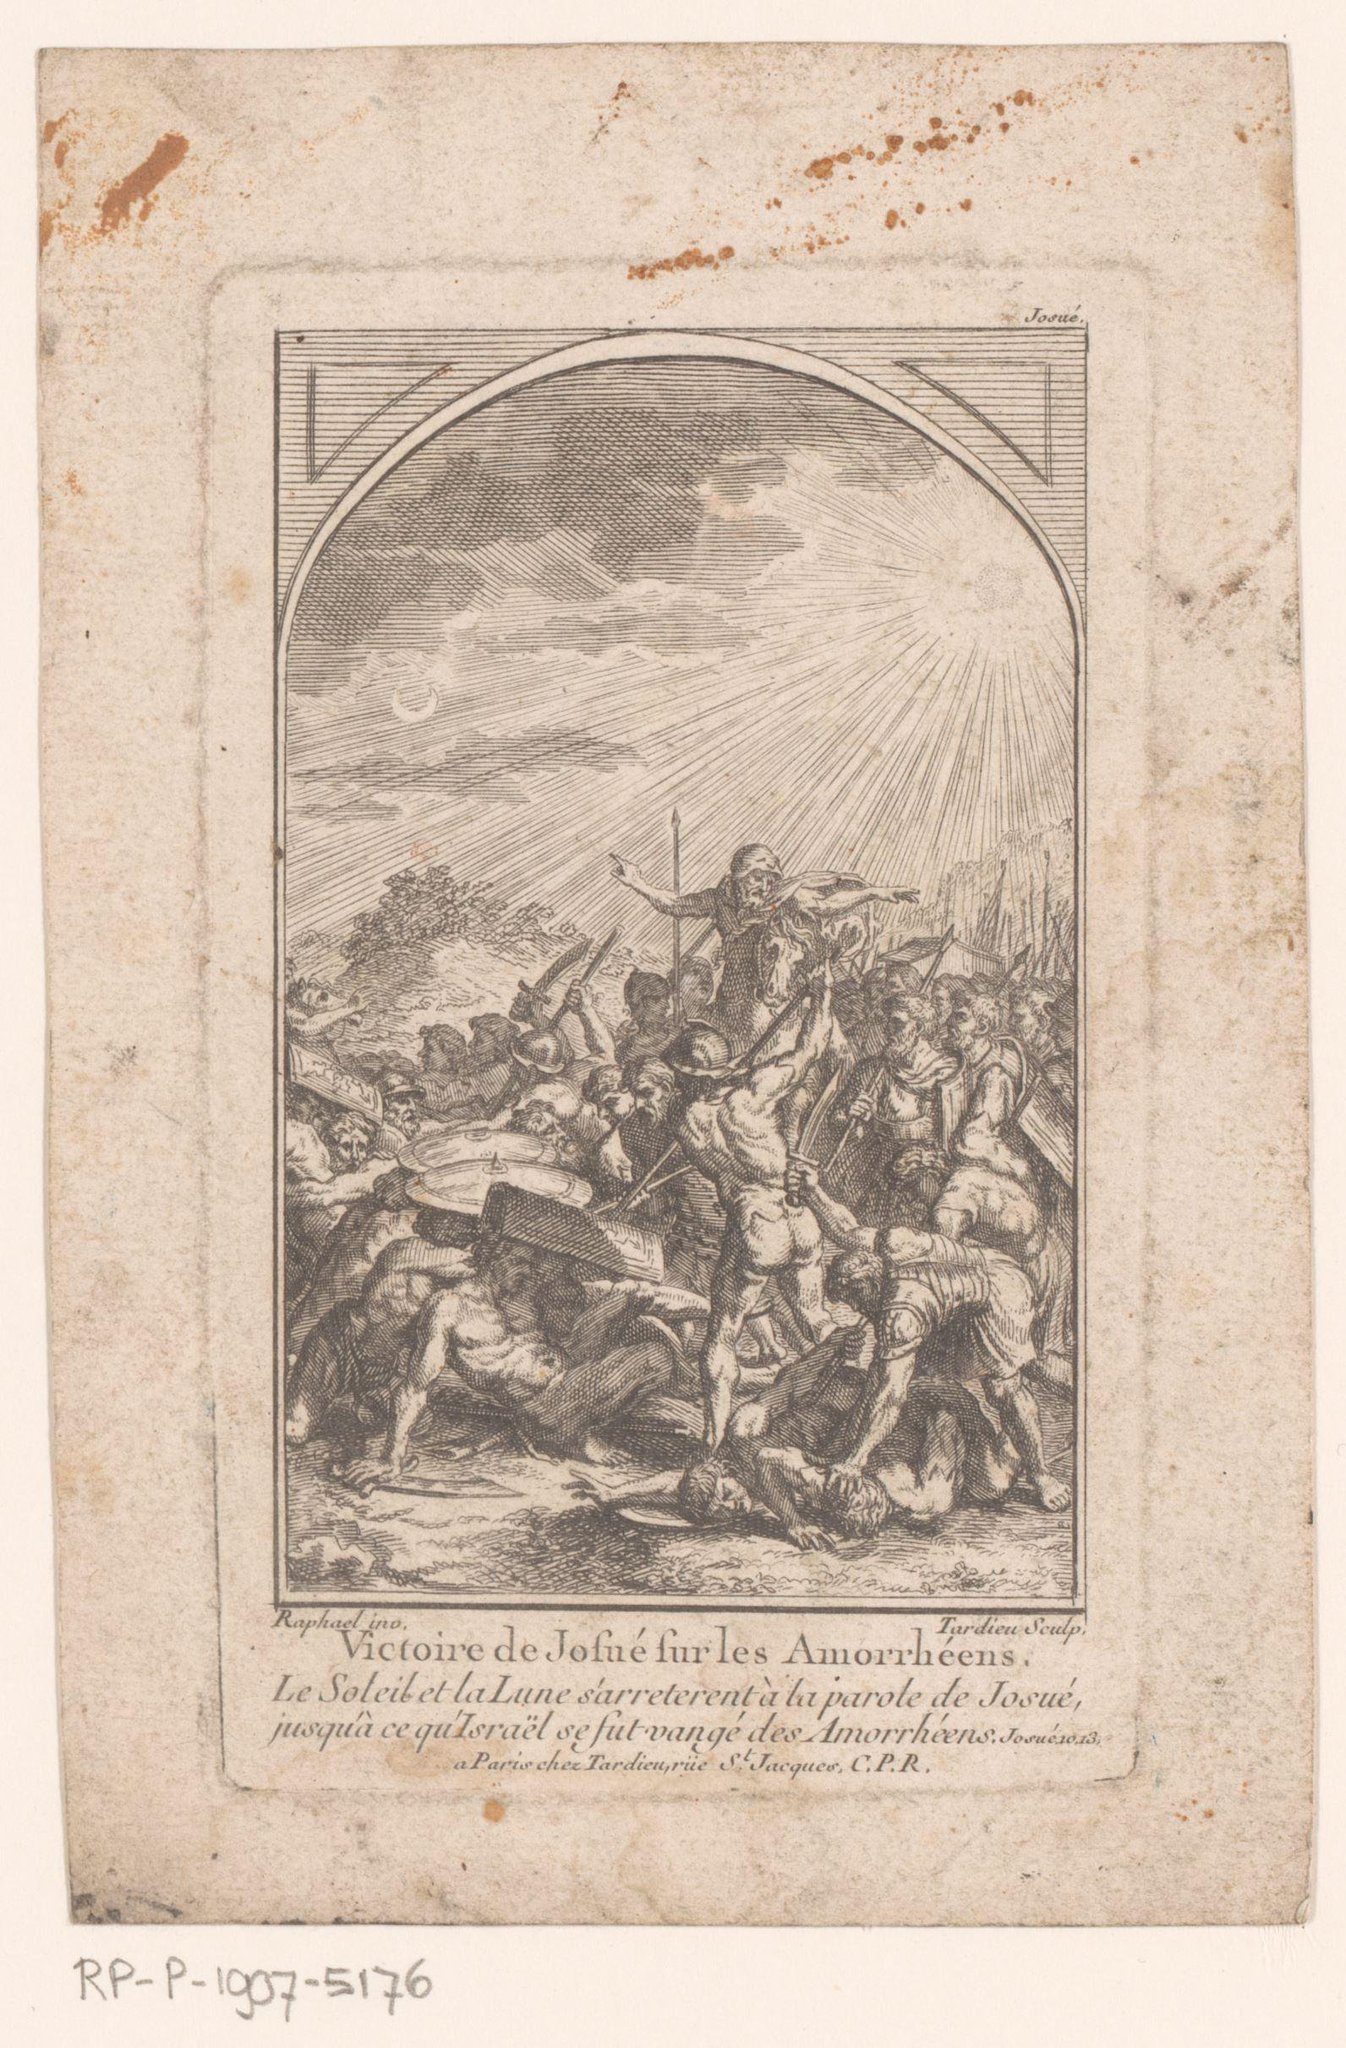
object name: print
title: Overwinning van de Israëlieten op de Amorieten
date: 1684-1749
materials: paper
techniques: engraving, etching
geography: paris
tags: battle of the israelites againts the amorites during their journey through the desert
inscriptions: collector's mark: Lugt 2228